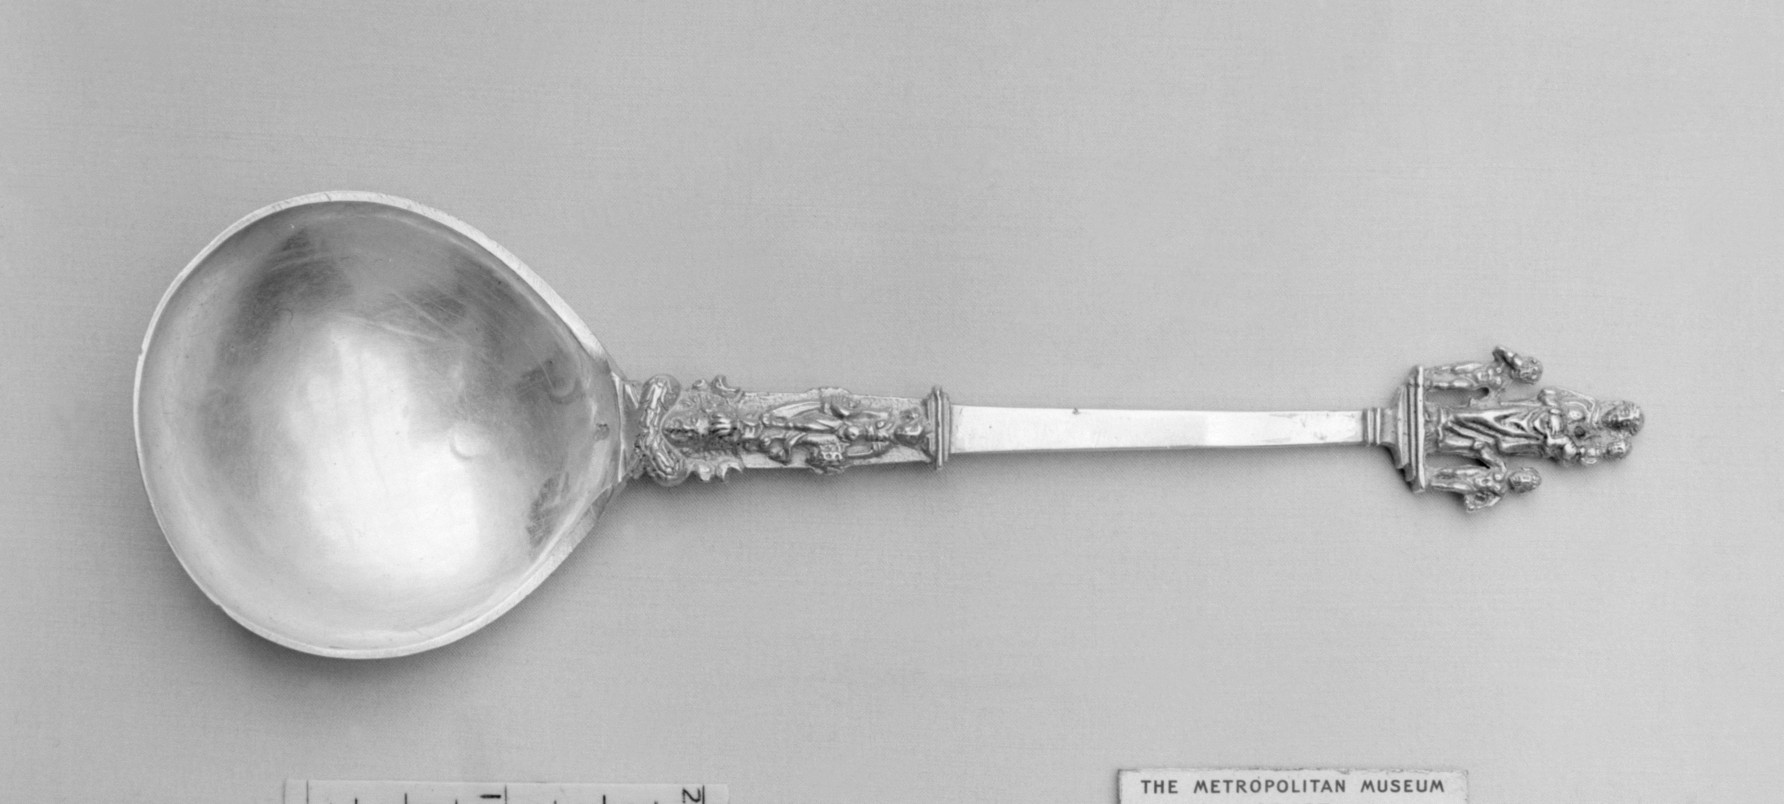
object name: spoon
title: Figure-top spoon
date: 1630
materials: silver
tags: infants,women